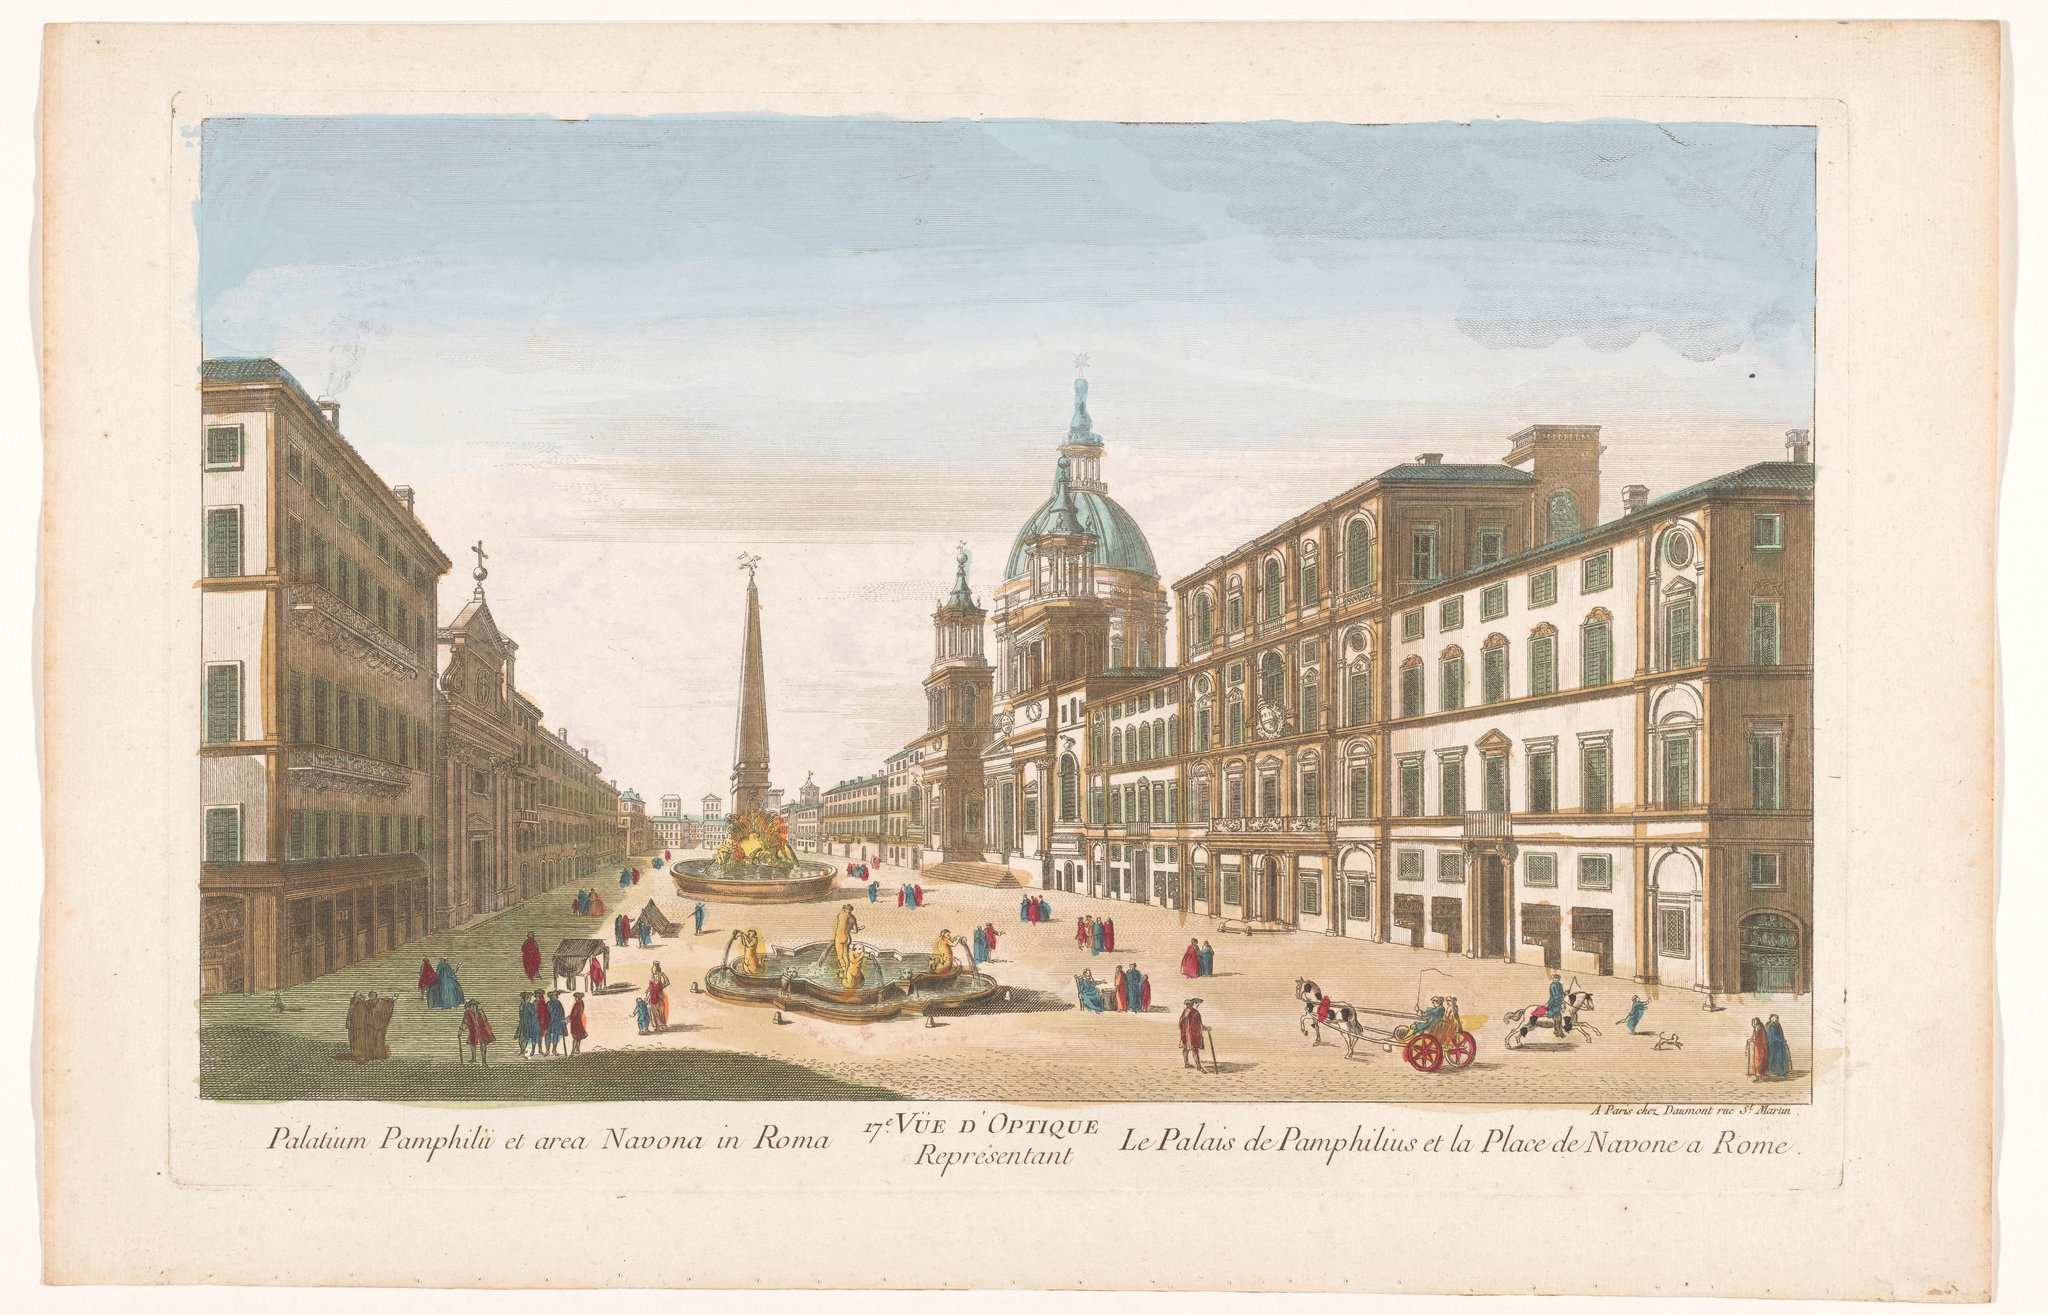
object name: print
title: Gezicht op het Palazzo Pamphili en het Piazza Navona te Rome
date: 1745-1775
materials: paper, watercolor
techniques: brush, etching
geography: paris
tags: obelisk, needle (+ city(-scape) with figures, staffage), palace, church (exterior), square, place, circus, etc. (+ city(-scape) with figures, staffage), ornamental fountain (+ city(-scape) with figures, staffage)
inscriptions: watermark, collector's mark: Lugt 2166